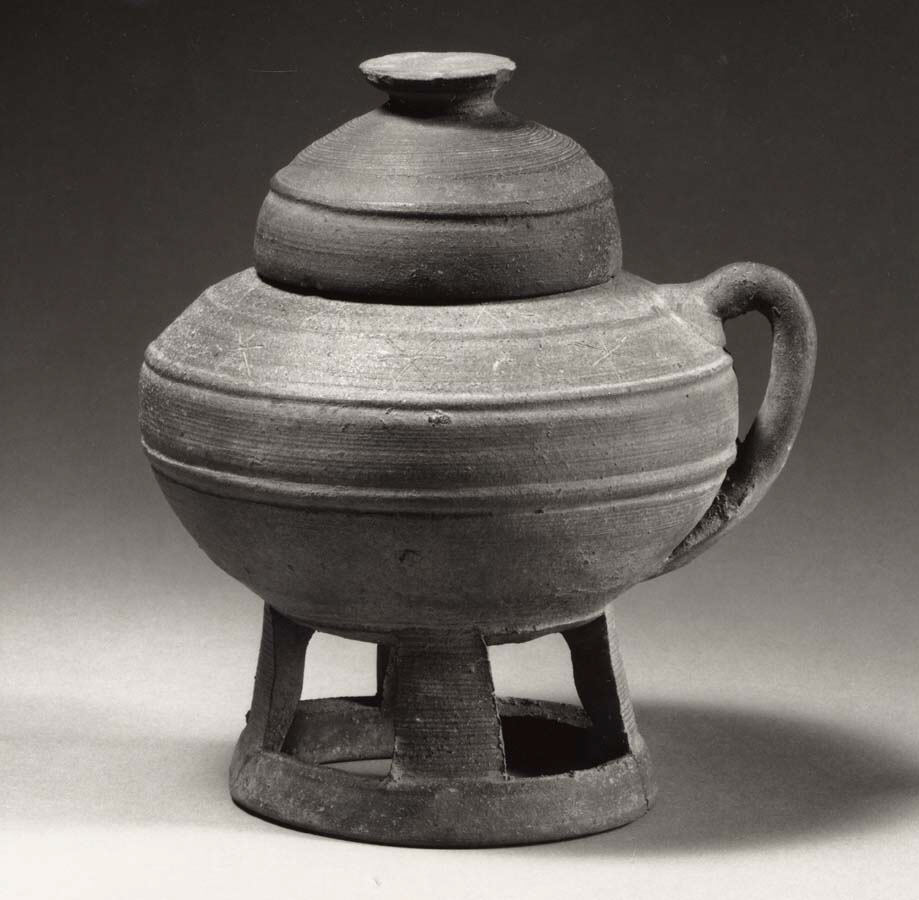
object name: pedestal jar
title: Pedestal jar with handle and lid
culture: korean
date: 401-600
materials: stoneware